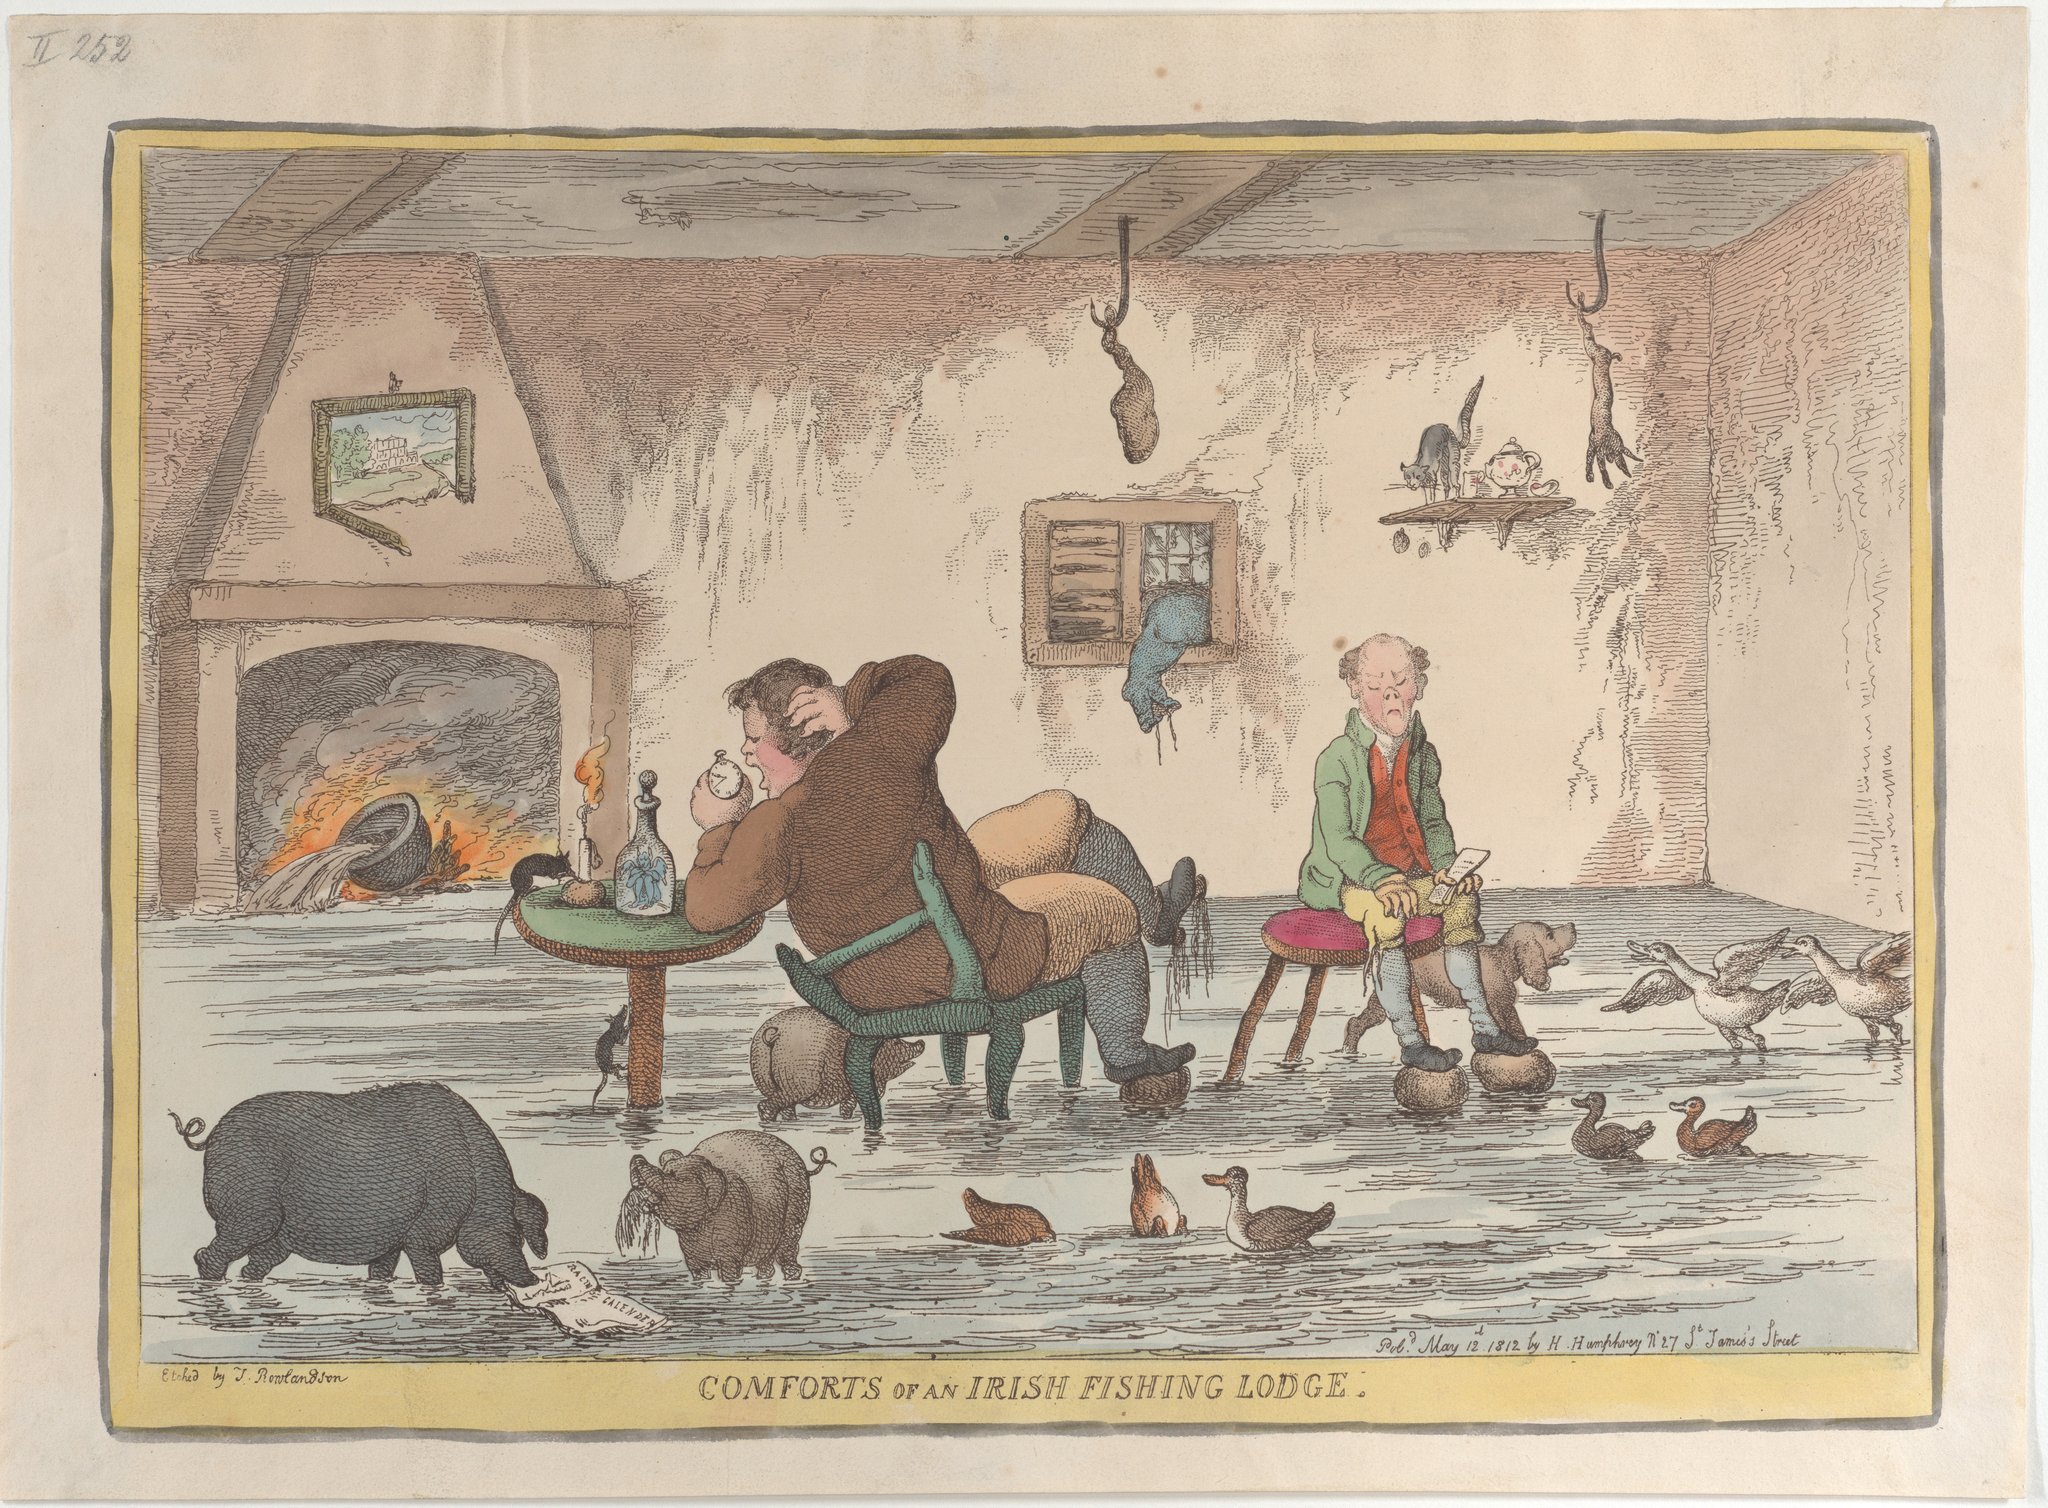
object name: print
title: Comforts of an Irish Fishing Lodge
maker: thomas rowlandson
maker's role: artist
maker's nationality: british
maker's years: 1757-1827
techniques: etching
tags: ducks,satire,interiors,men,dogs,pigs